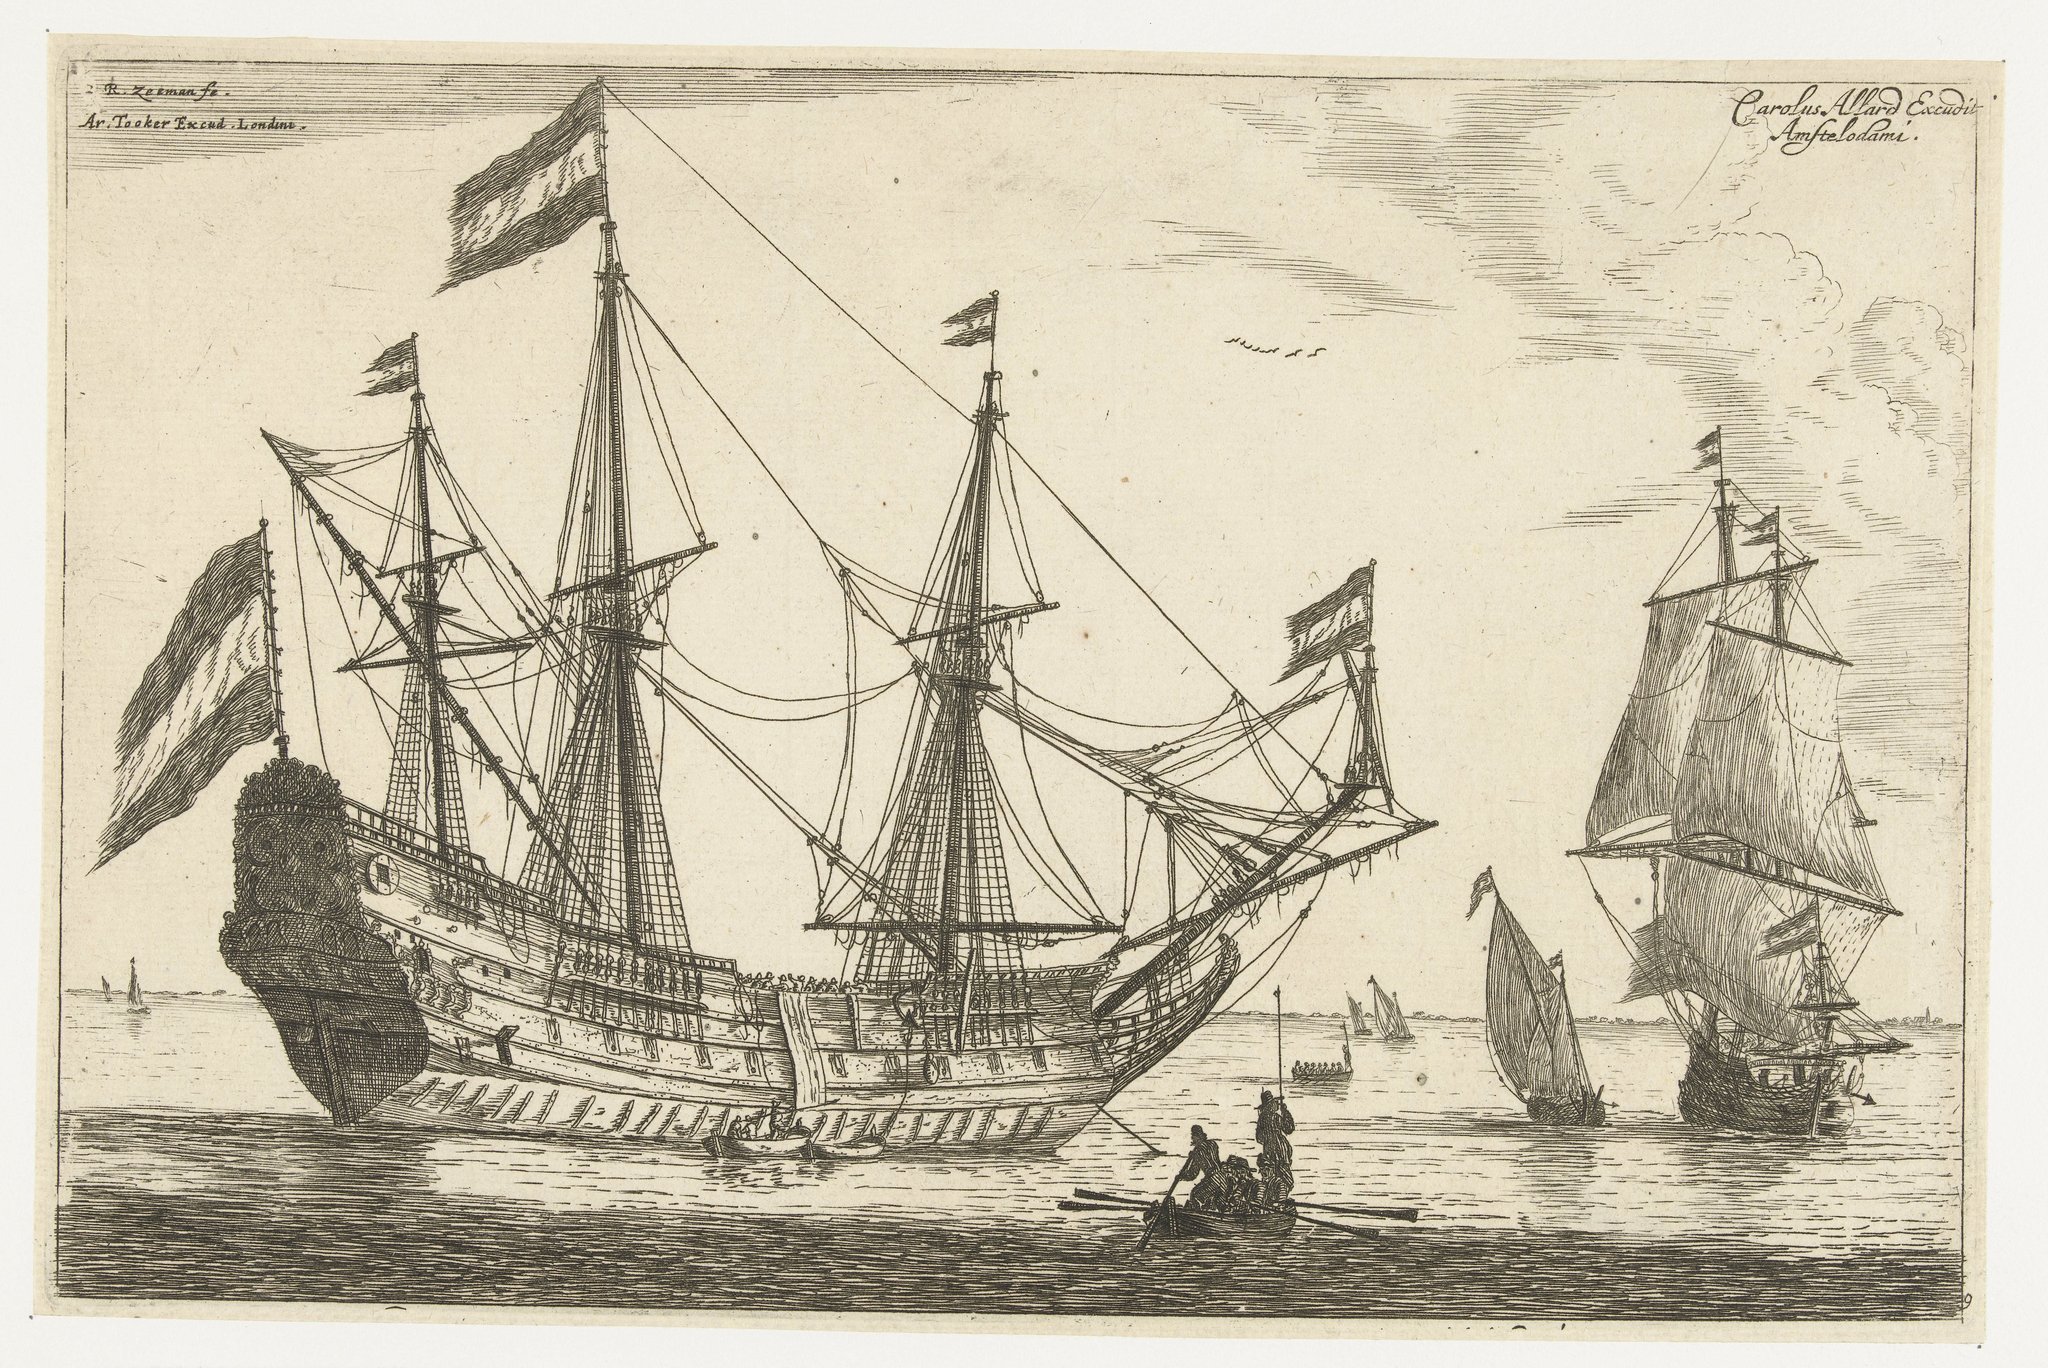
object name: print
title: Dertien scènes met schepen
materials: paper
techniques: etching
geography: netherlands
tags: sailing-ship, sailing-boat, rowing-boat, canoe, etc.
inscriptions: number: ‘9’, collector's mark: Lugt 2228a, number: ‘2’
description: Een groot Nederlands zeilschip met gestreken zeilen, dit zou het schip "De Parel" kunnen zijn. Op het water nog enkele zeilschepen en twee roeiboten.